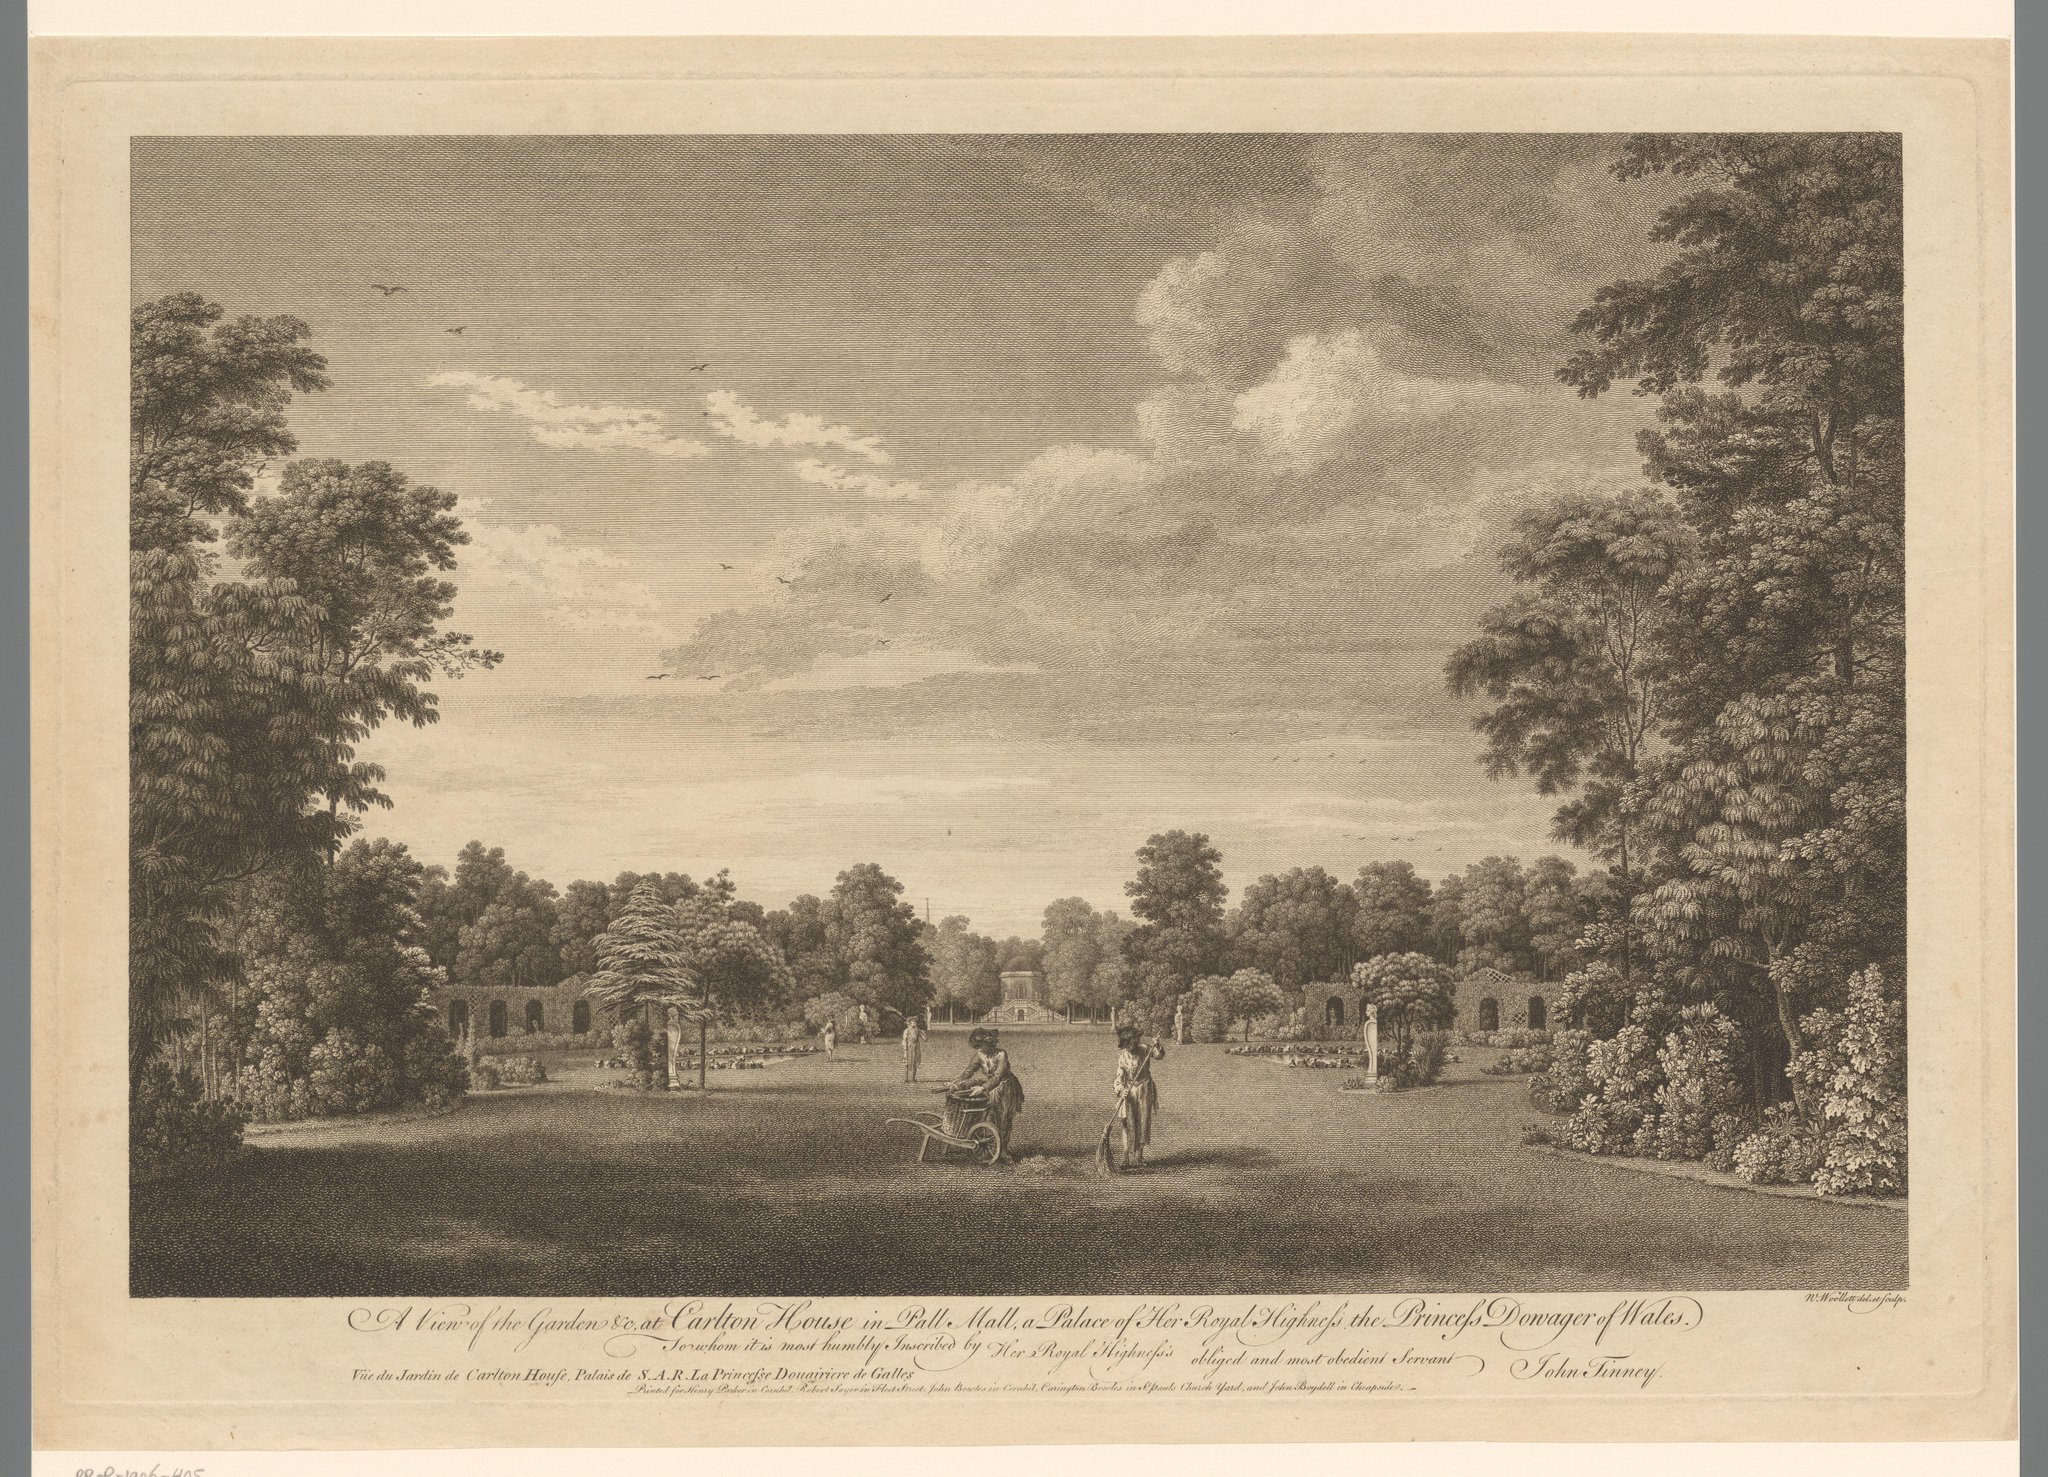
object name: print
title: Gezicht op de tuin van Carlton House bij Pall Mall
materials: paper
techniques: etching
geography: london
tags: london, augusta van saksen-gotha, english or landscape garden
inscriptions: collector's mark: Lugt 2228